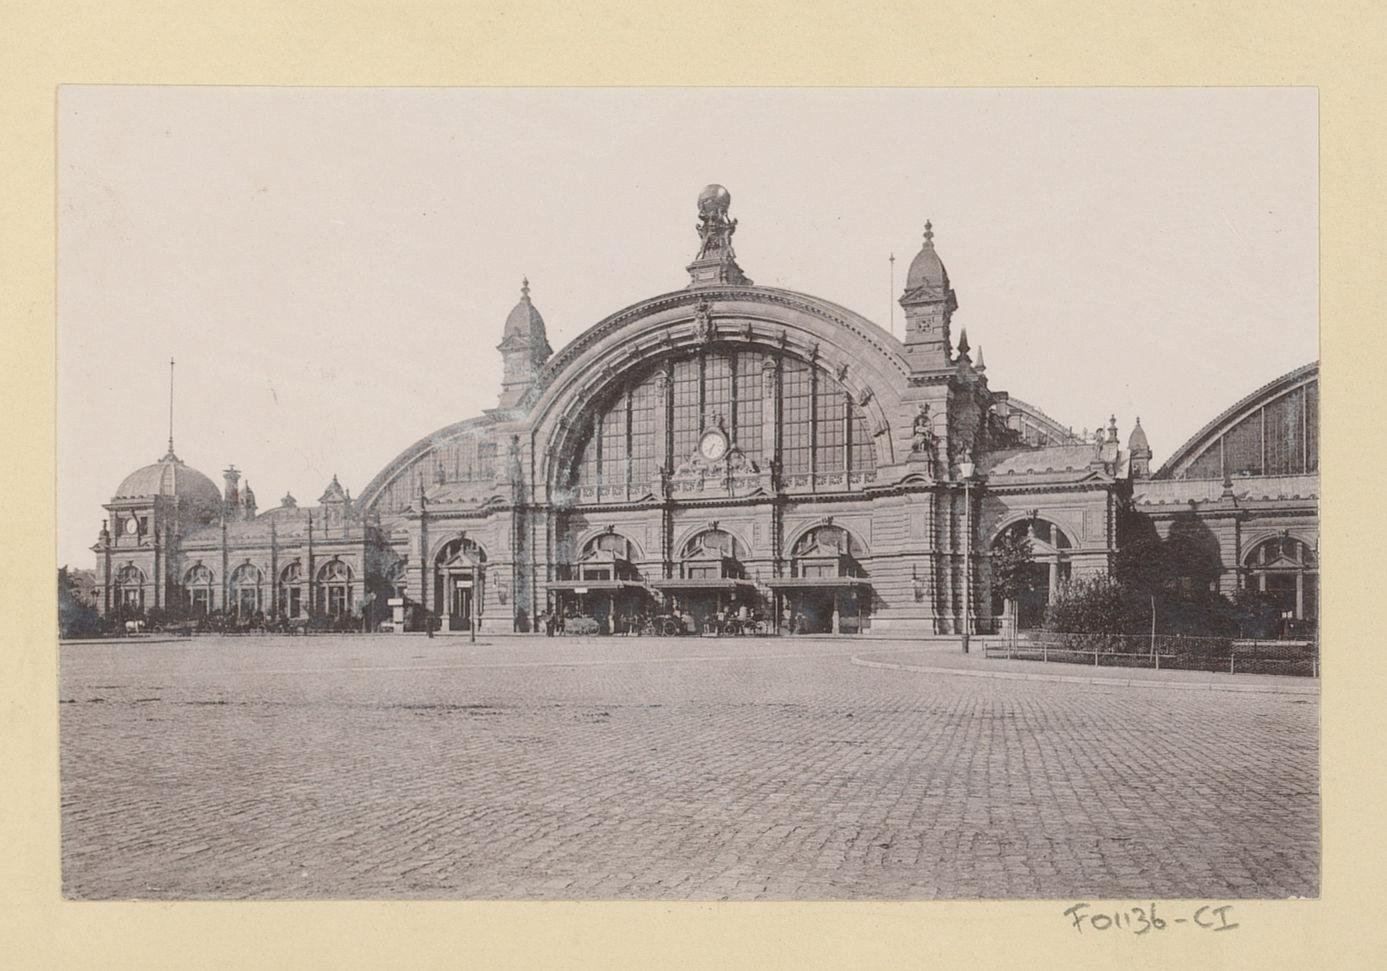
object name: photomechanical print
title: Exterieur van de Hauptbahnhof van Frankfurt am Main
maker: Anonymous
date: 1888-1895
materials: paper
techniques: photograph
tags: station; shelter (railway, tramway)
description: Onderdeel van Fotoalbum met opnames van bezienswaardigheden in België, Duitsland en Noorwegen.